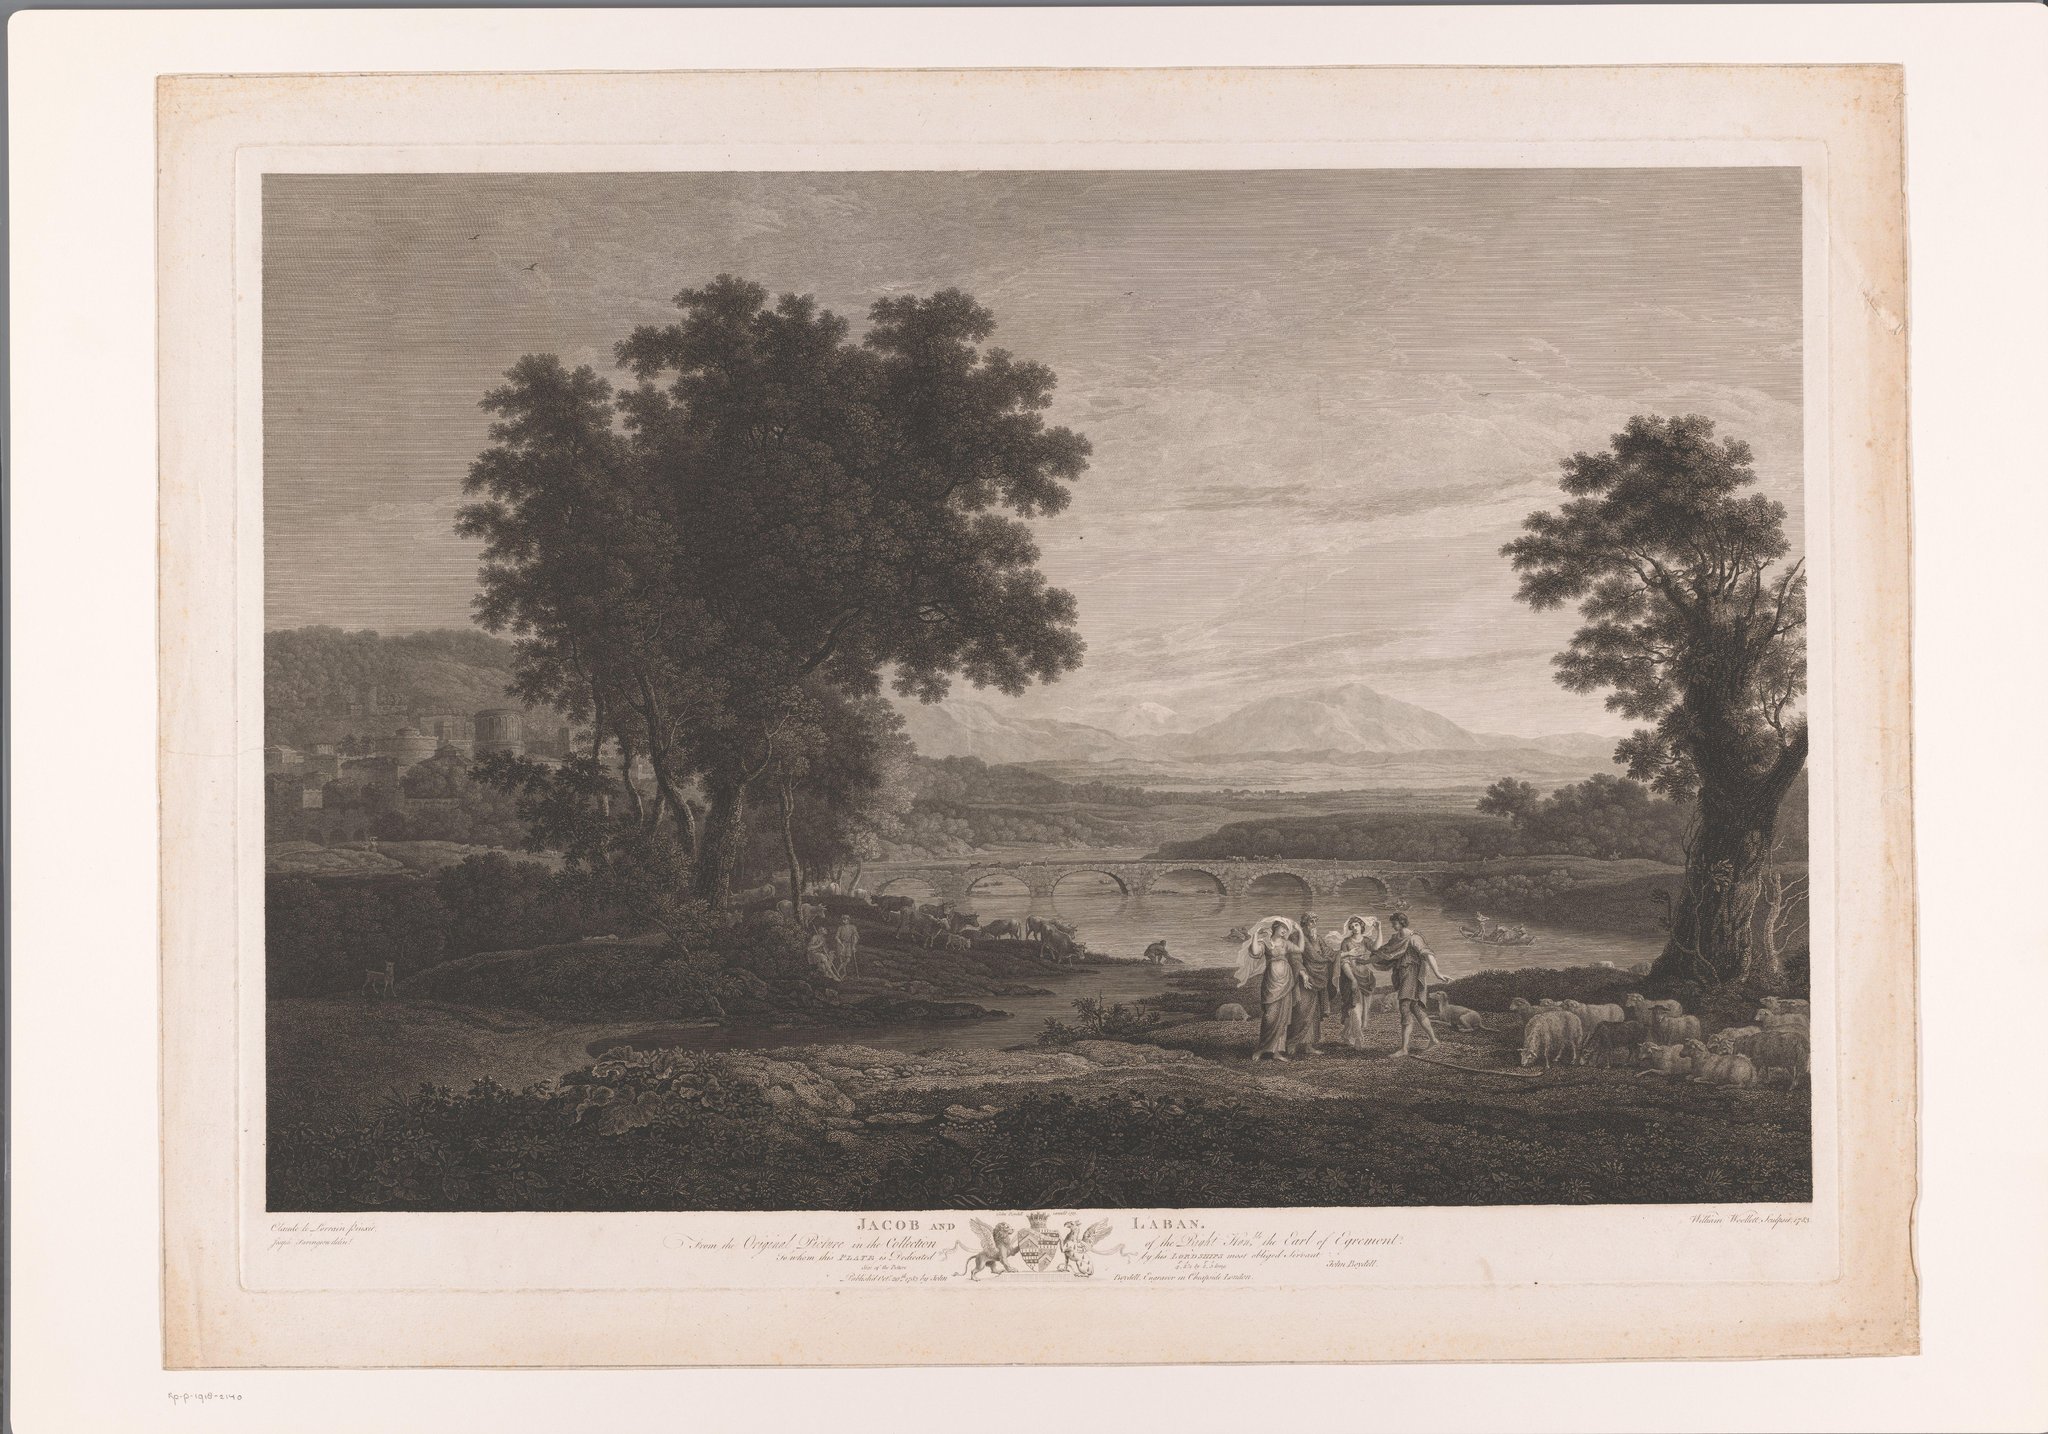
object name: print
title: Jacob and Laban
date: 1783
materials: paper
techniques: engraving, etching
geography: england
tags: the partnership with laban ~ story of jacob (genesis 30:25-43)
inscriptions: collector's mark: Lugt 2233